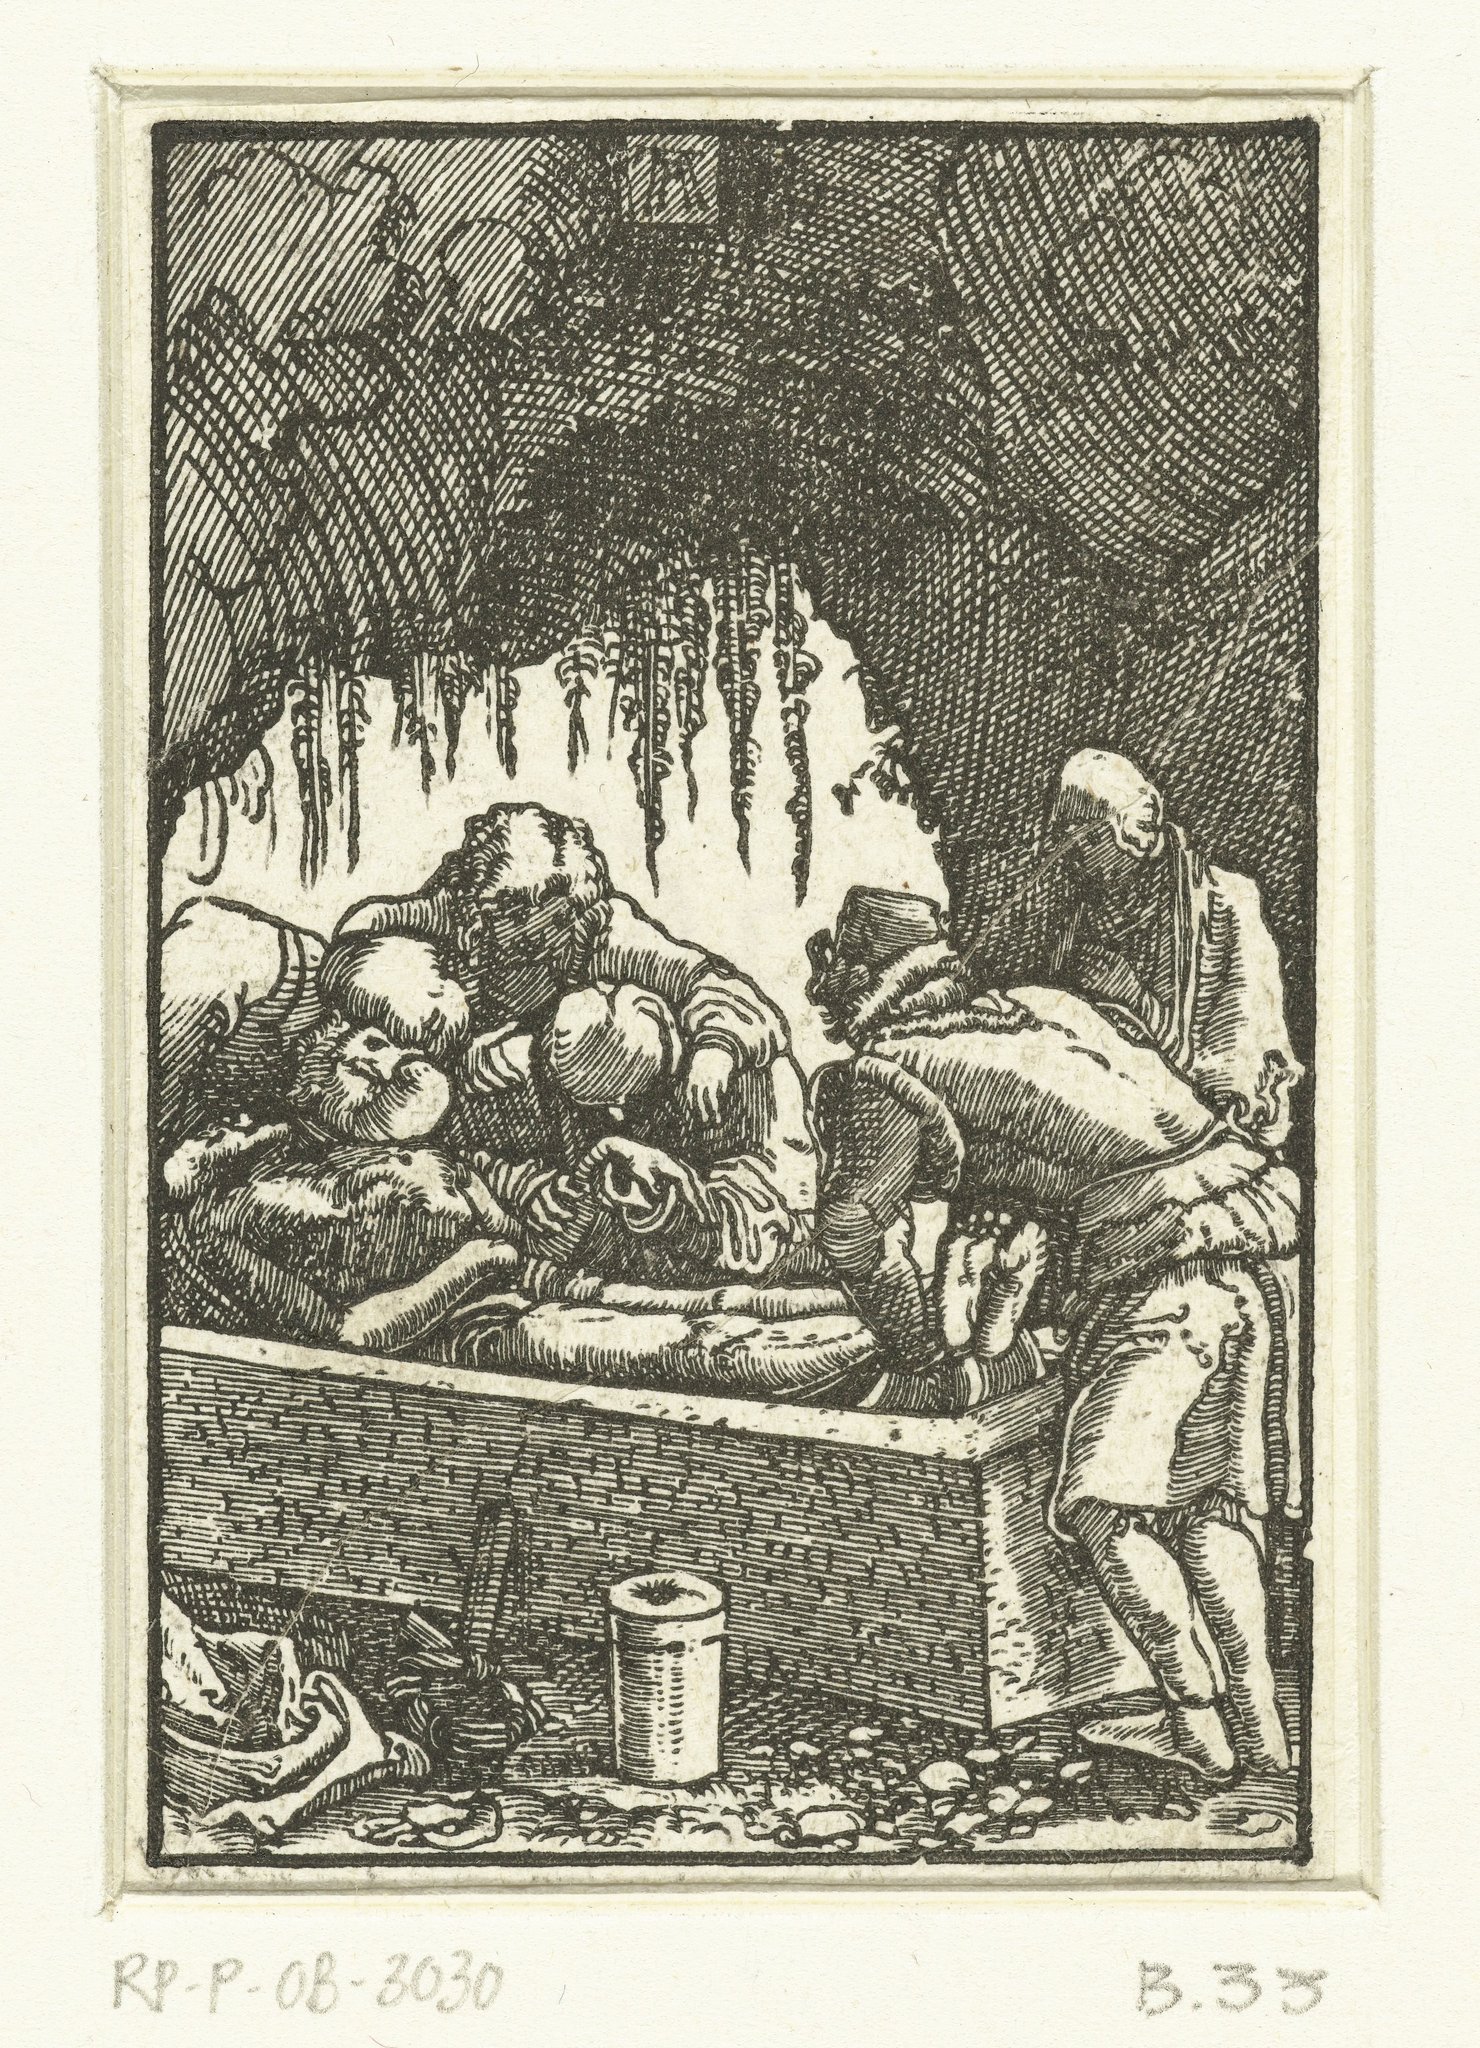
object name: print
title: De val en verlossing van de mensheid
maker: albrecht altdorfer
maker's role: draughtsman, print maker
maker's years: 1480-1538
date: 1506-1538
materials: paper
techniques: woodcut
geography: germany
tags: christ's entombment (possibly by angels)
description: Het lichaam van Christus door twee mannen in een graftombe gelegd. Maria houdt de hand van Christus vast en wordt getroost door Johannes. Maria Magdalena kijkt toe. Drieëndertigste prent uit een serie van veertig.